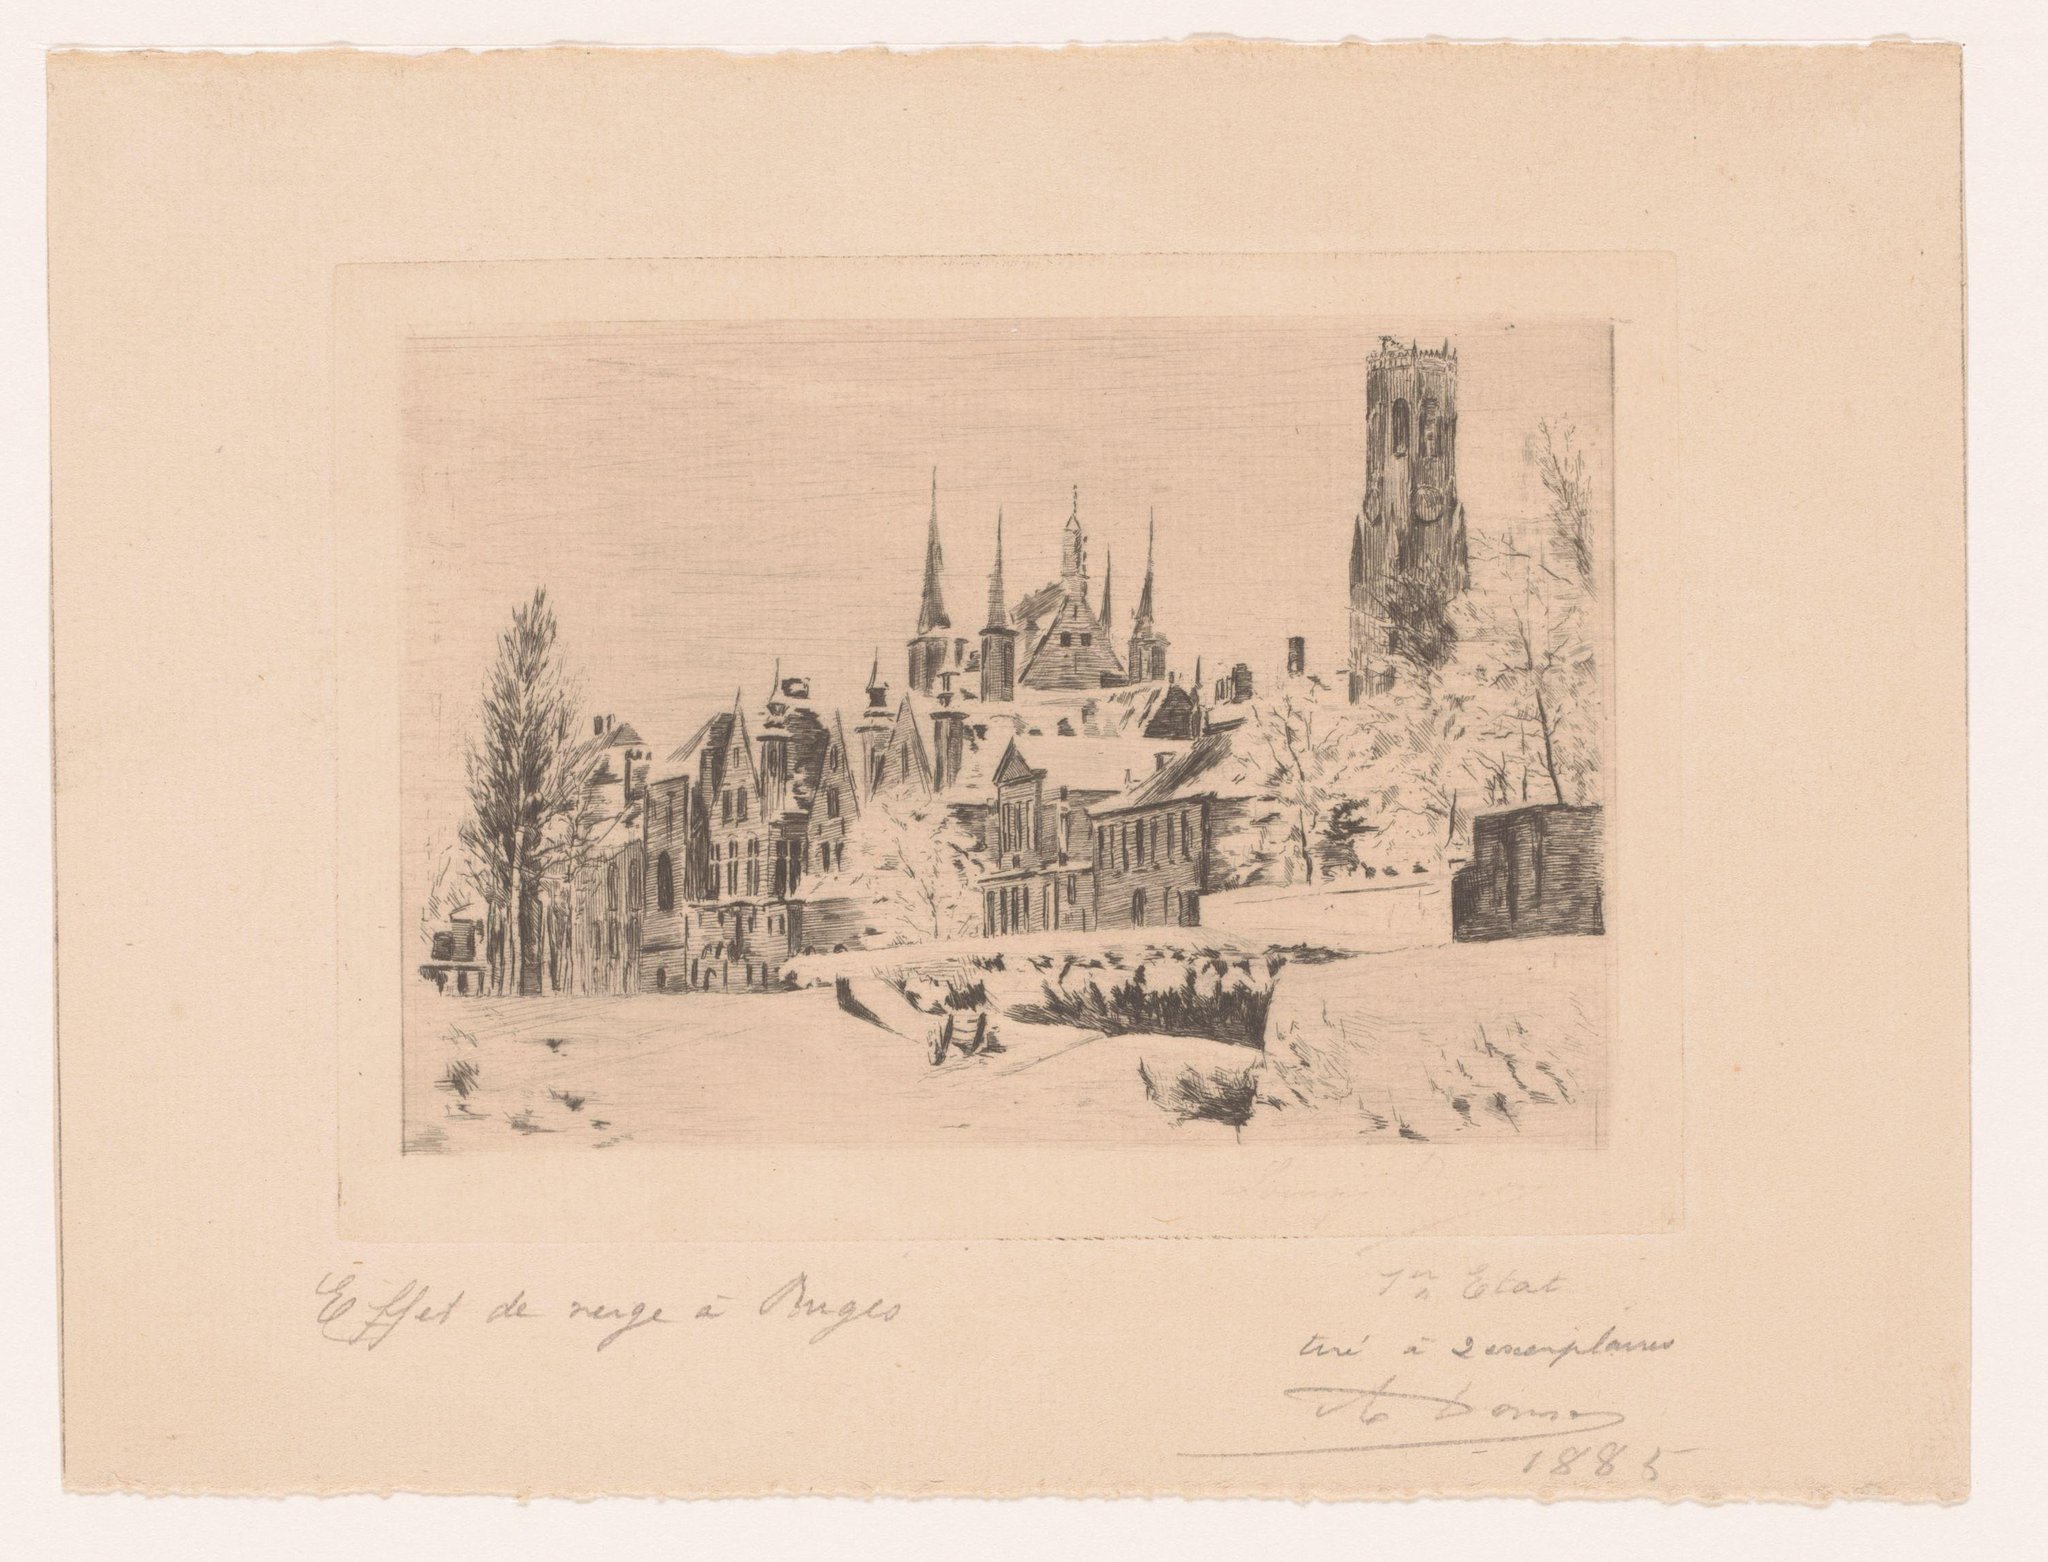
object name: print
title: Effet de neige à Bruges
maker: auguste danse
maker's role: print maker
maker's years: 1829-1929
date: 1885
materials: paper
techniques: drypoint, etching, intaglio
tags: prospect of city, town panorama, silhouette of city, bruges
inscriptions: annotation: ‘1er Etat tiré à 2 exemplaires’, collector's mark: Lugt 2228